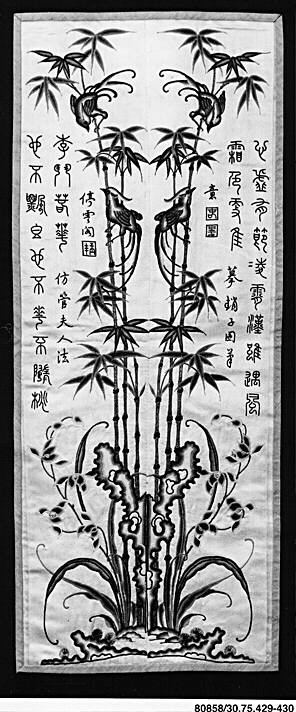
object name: sleeve band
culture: chinese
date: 1801-1900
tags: plants